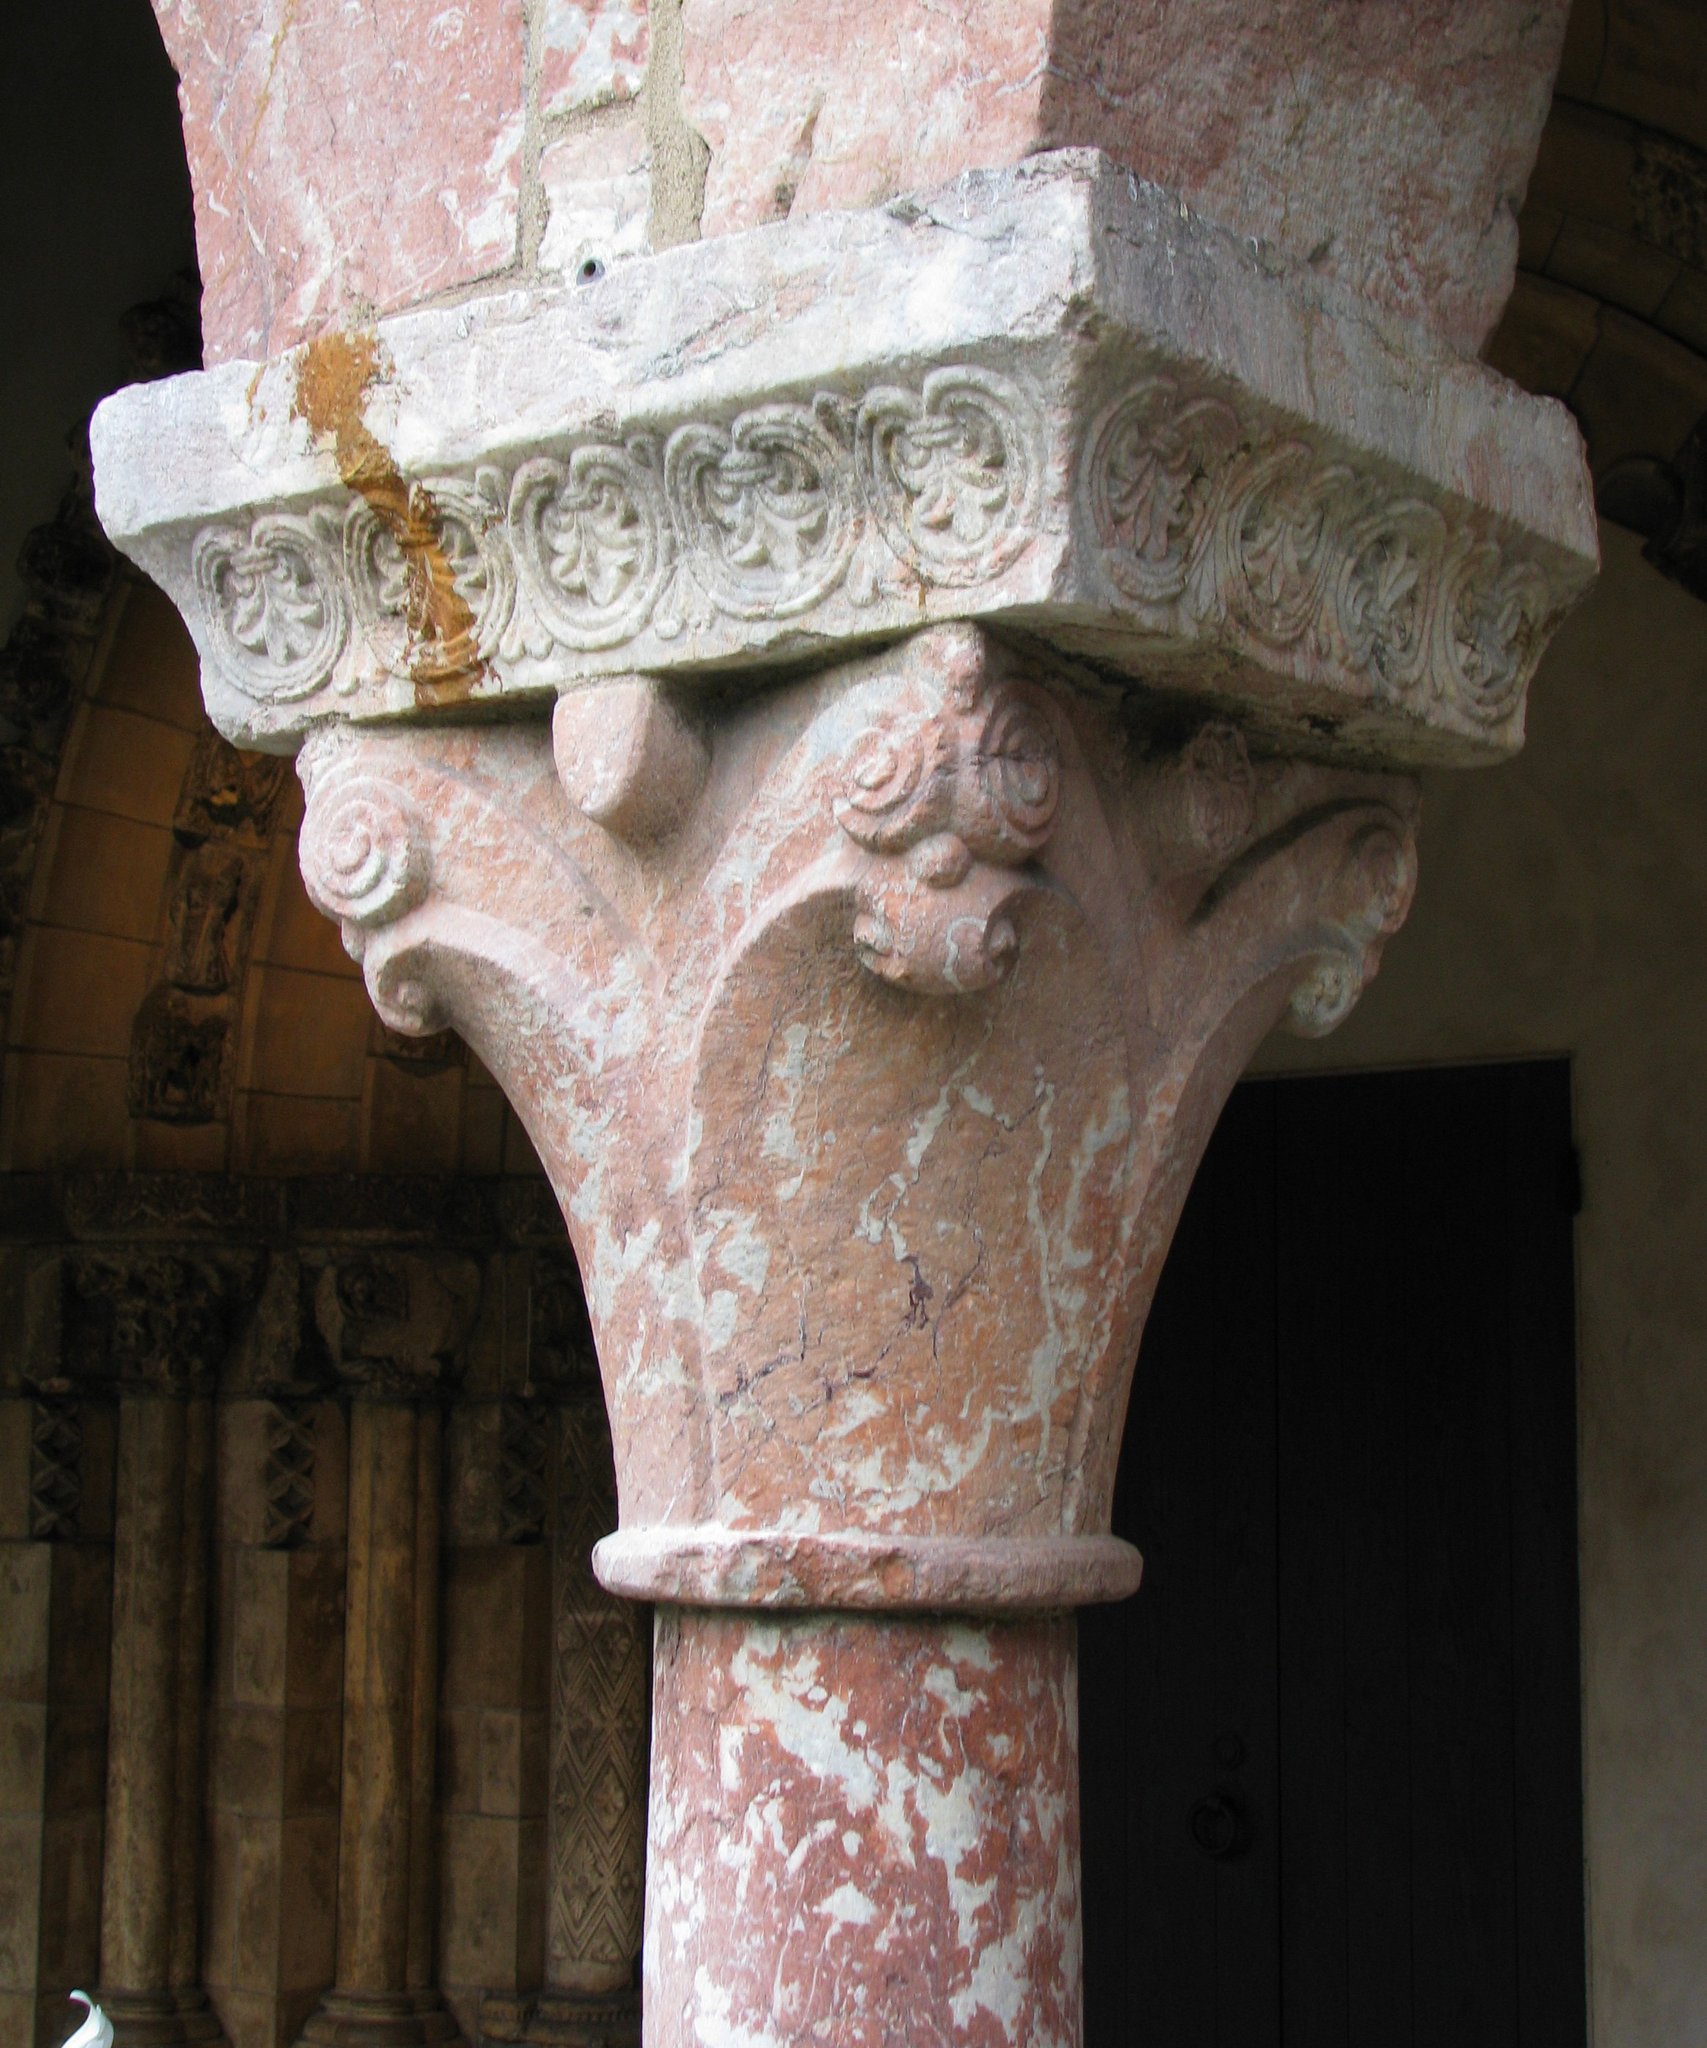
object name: capital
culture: catalan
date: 1130-1140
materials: marble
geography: france